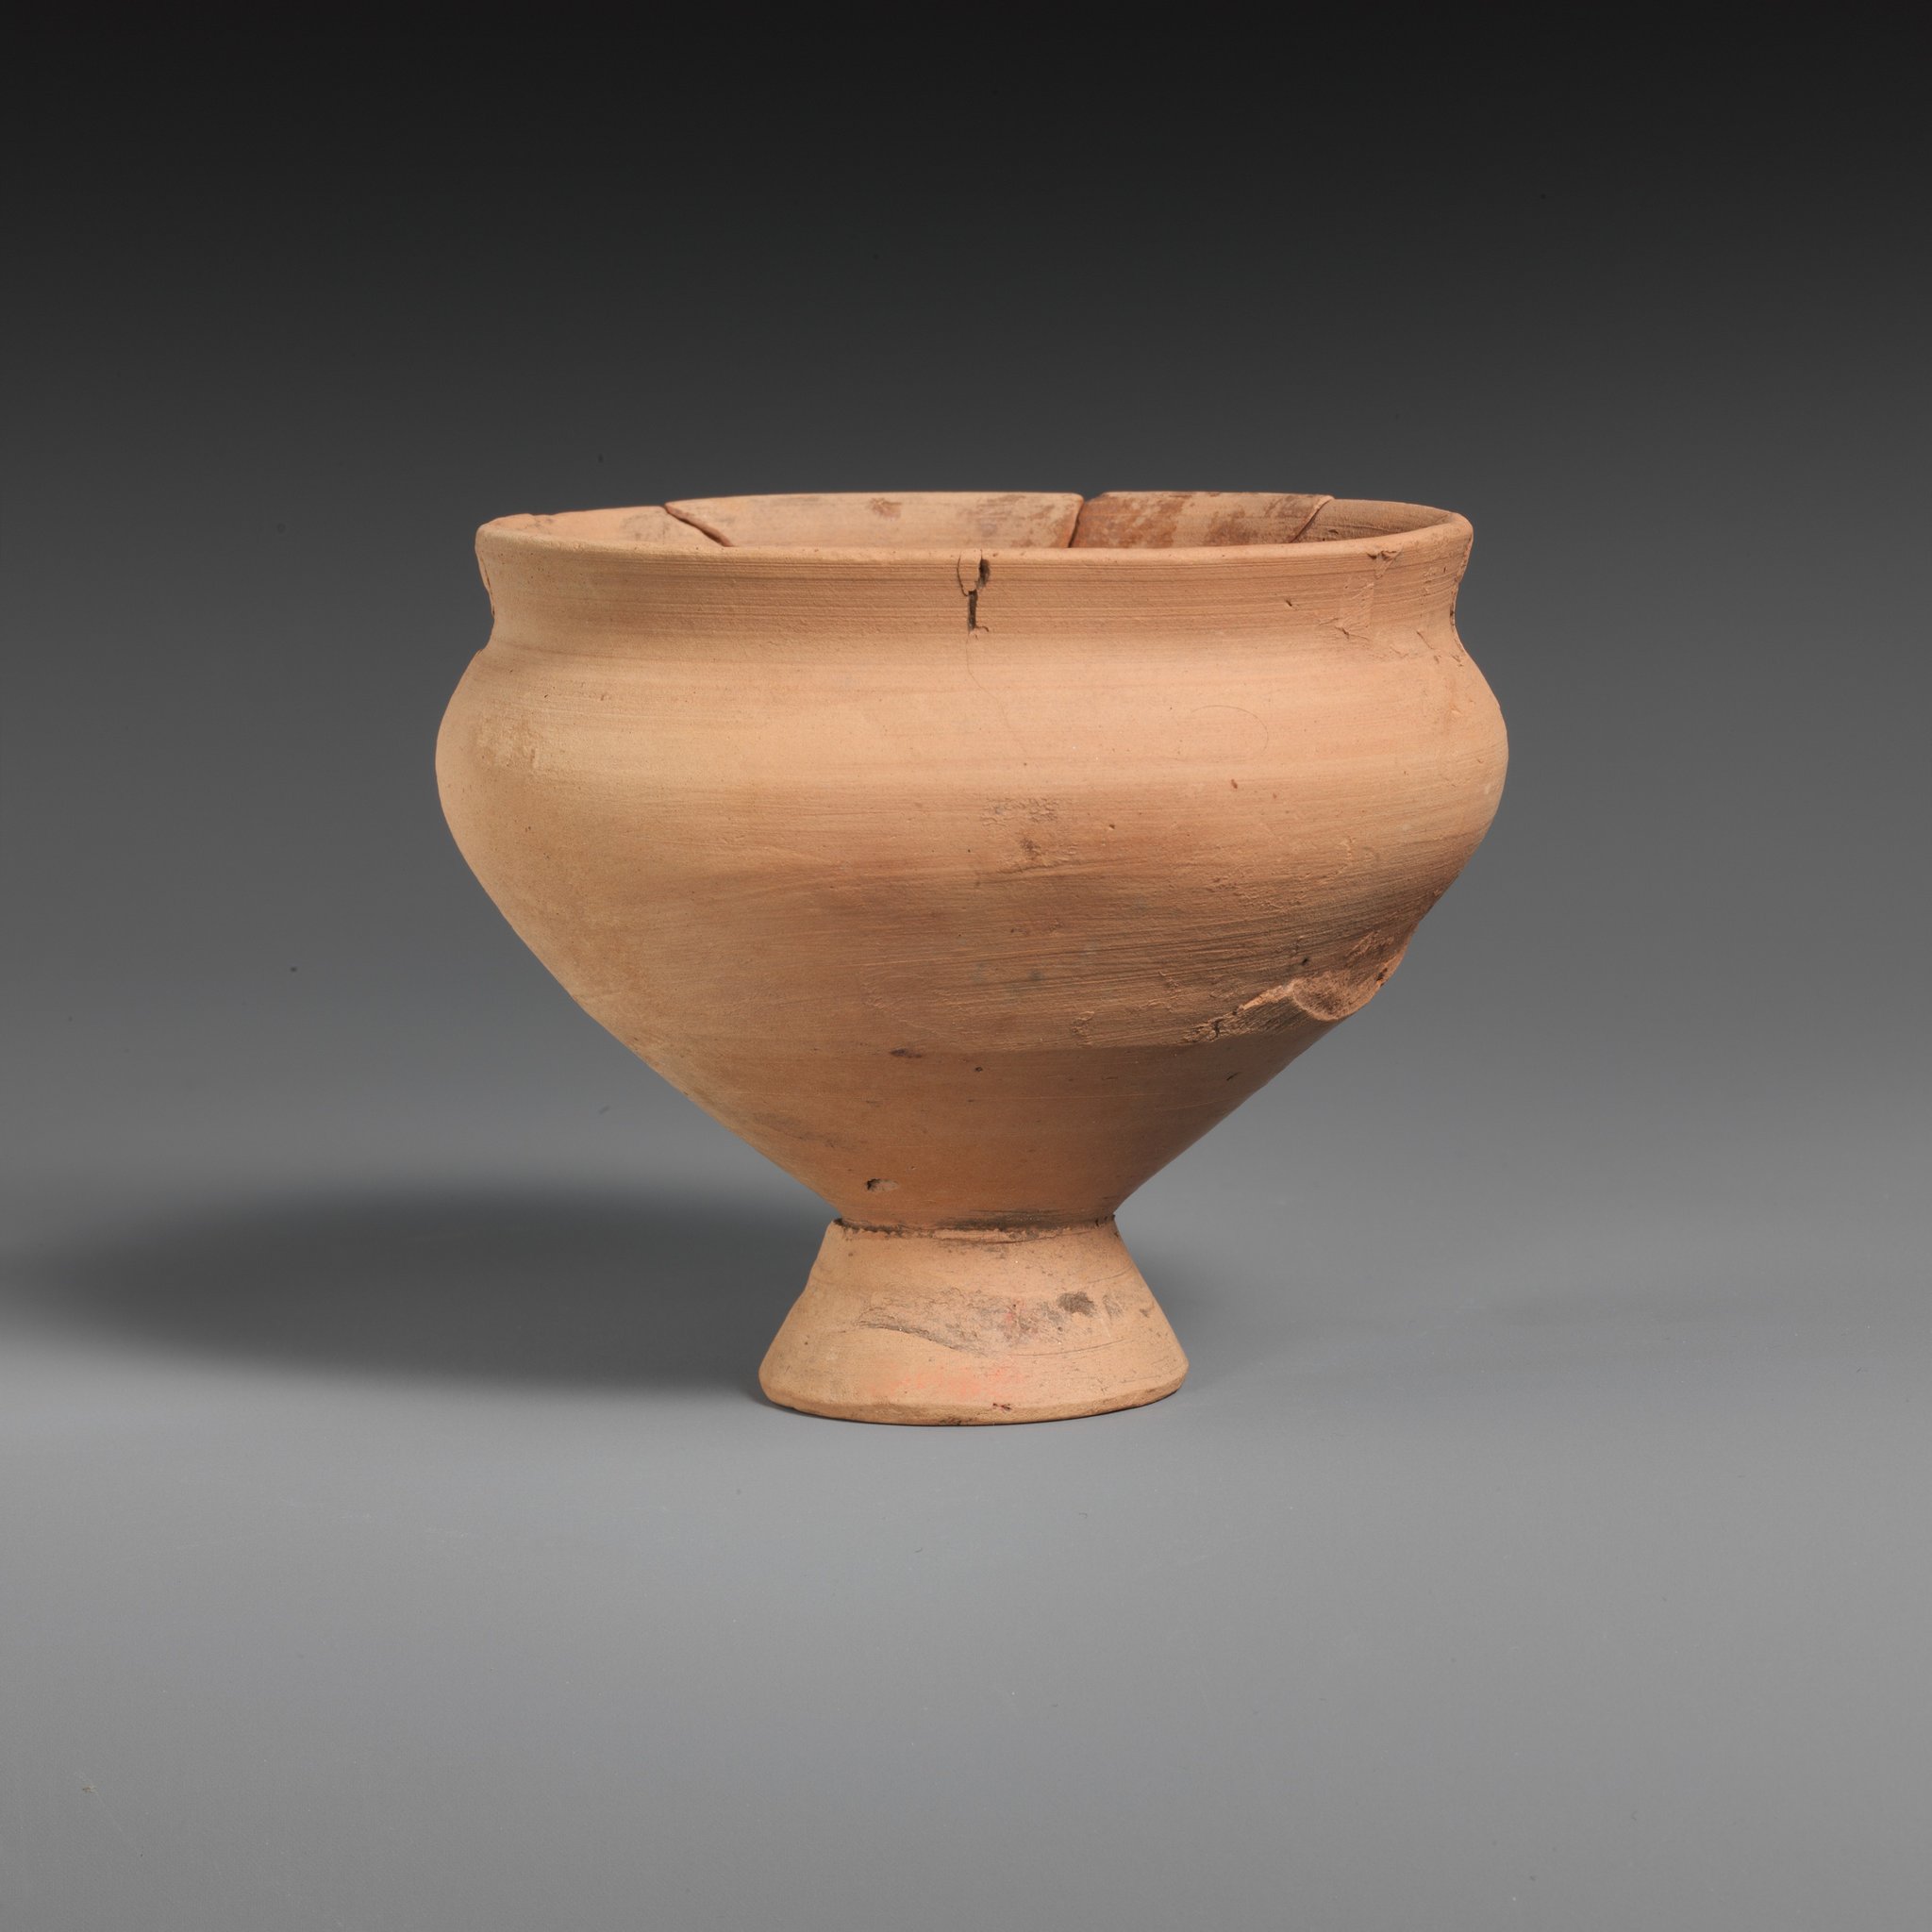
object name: kantharos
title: Terracotta kantharos (drinking cup with high handles)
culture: greek, attic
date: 700-601 BCE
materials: terracotta